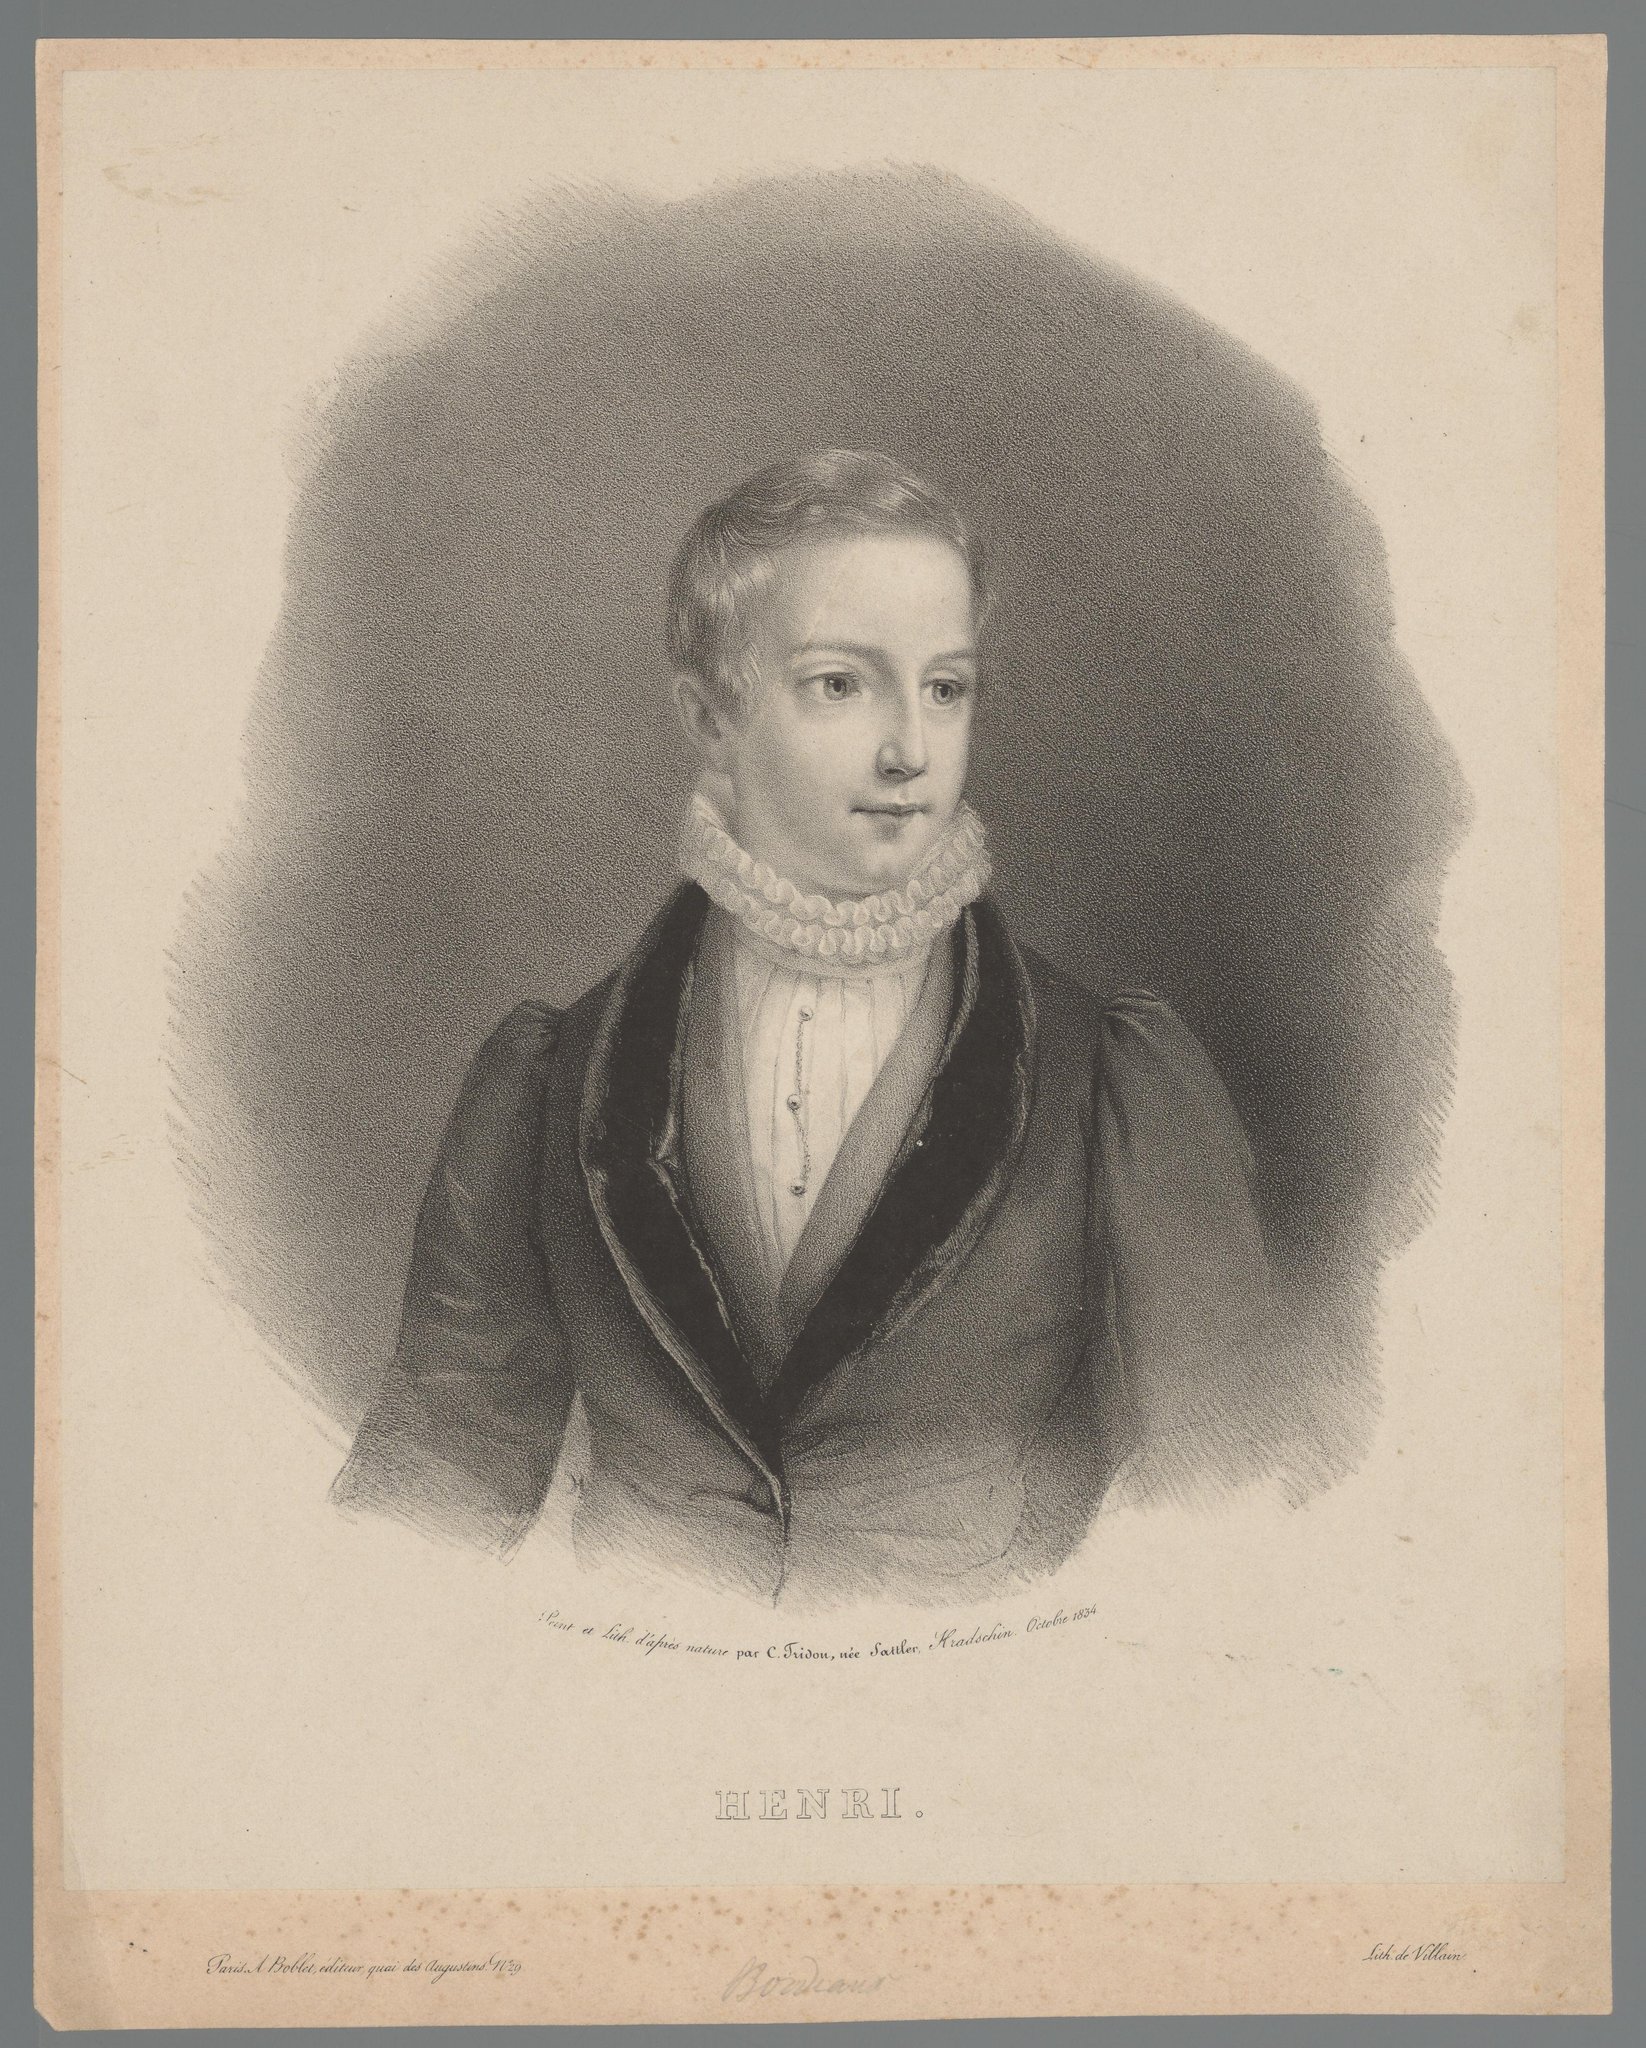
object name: print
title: Portret van een onbekende jongen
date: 1834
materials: paper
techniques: lithograph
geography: paris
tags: historical persons, youth, adolescent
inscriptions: collector's mark: Lugt 2228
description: Portret van een verder onbekende jongen, met de naam Henri.